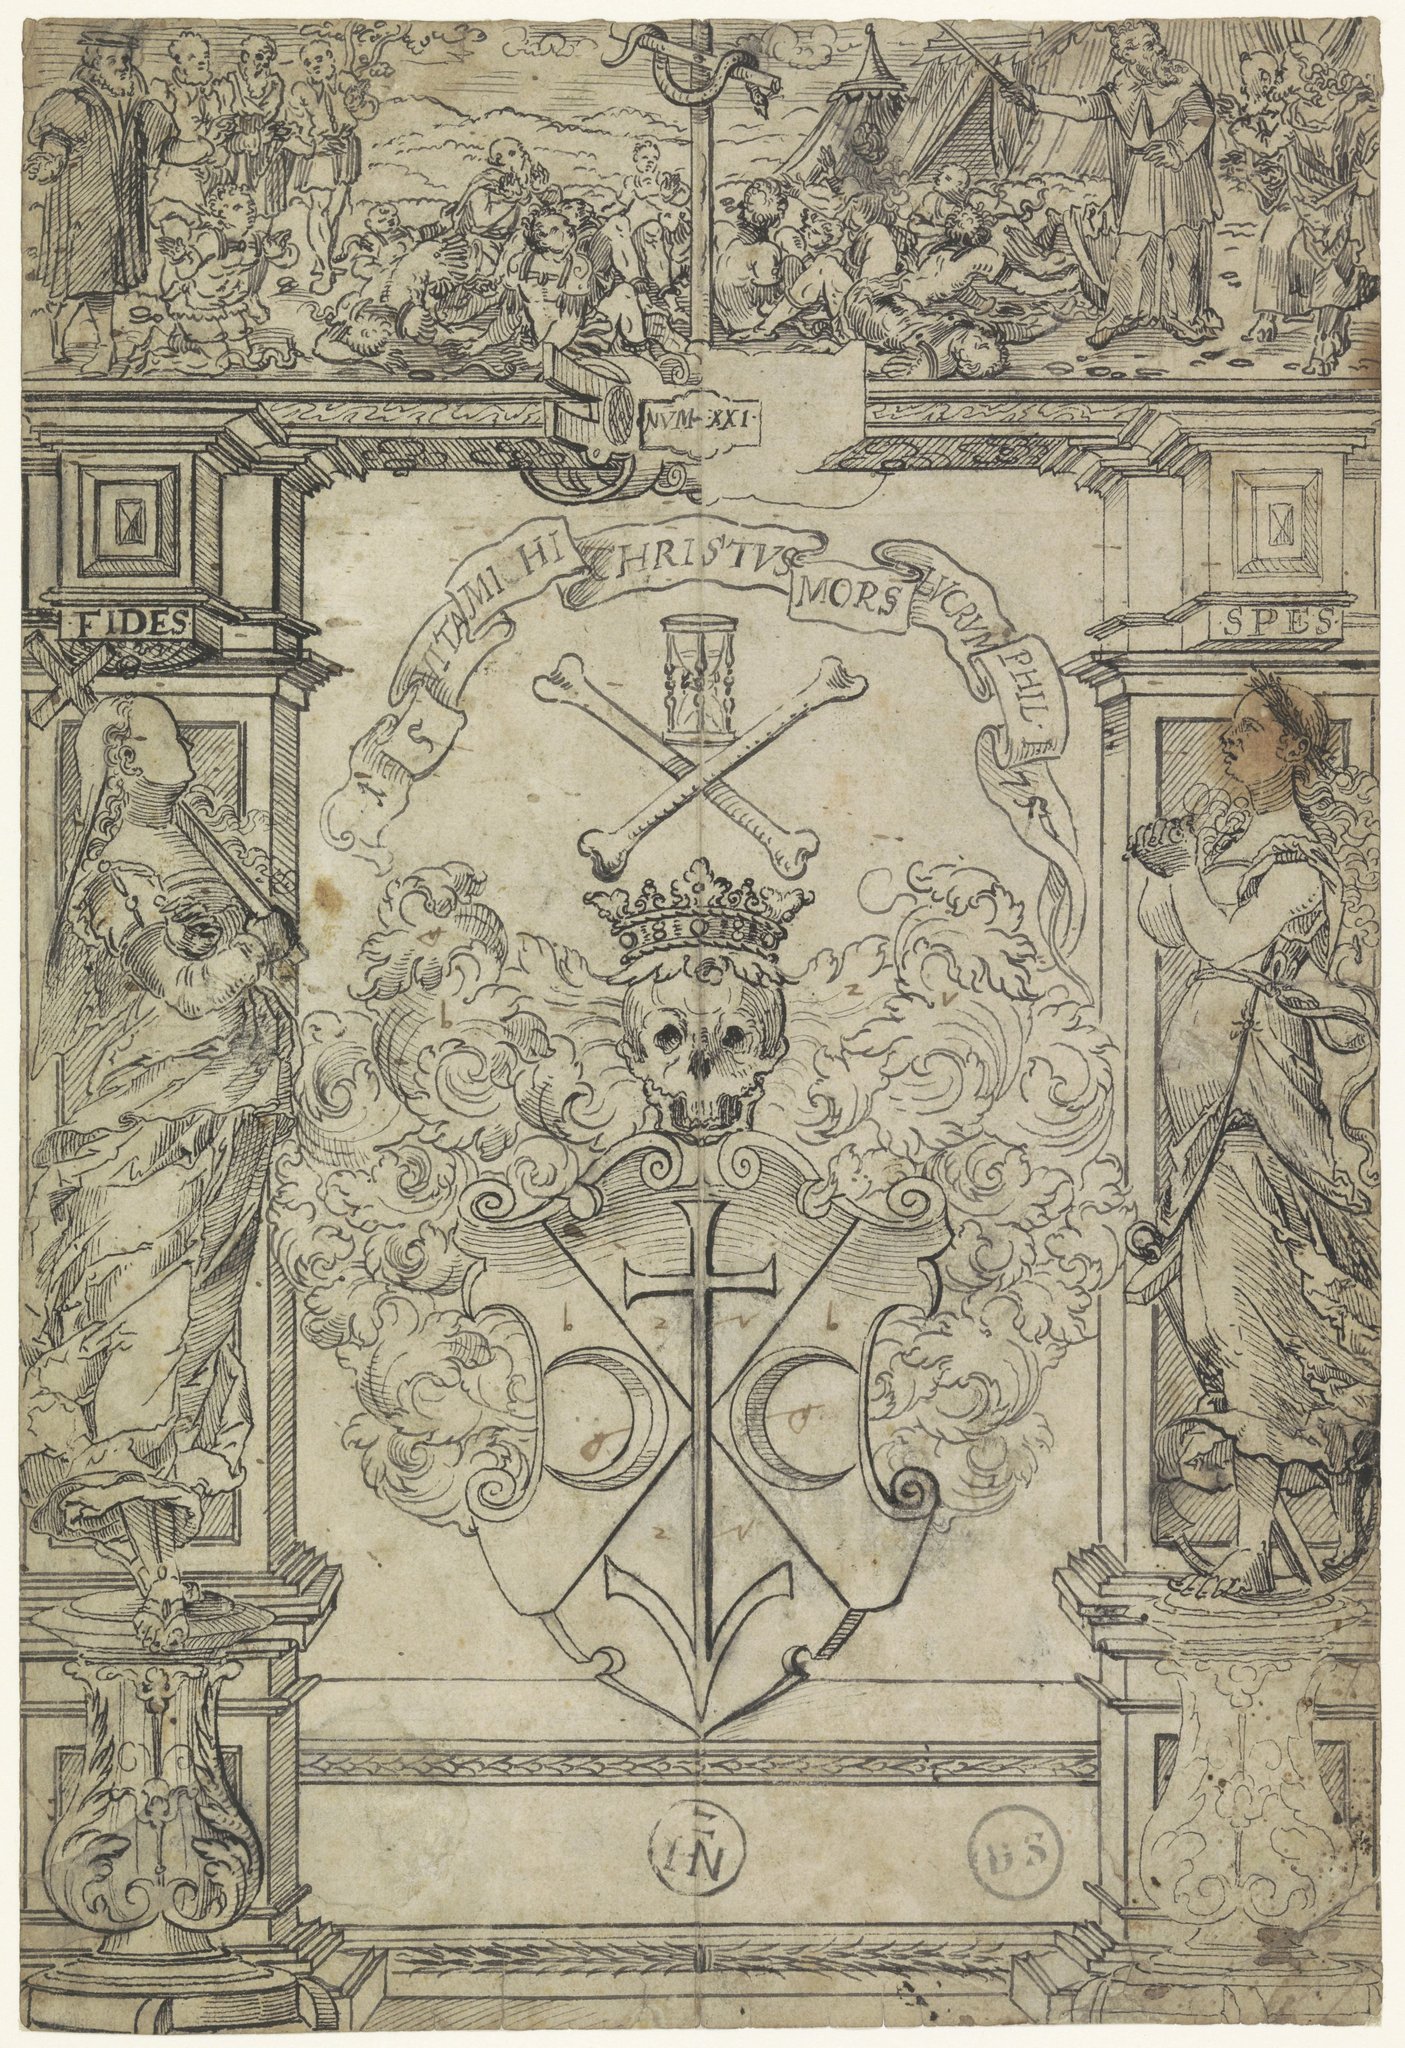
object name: drawing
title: Ontwerp voor een glasraam met een wapen, de figuren Fides en Spes, en Mozes en de koperen slang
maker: Anonymous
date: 1500-1600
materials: ink, paper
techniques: pen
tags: hope, 'spes'; 'speranza divina e certa' (ripa) ~ one of the three theological virtues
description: Ontwerp voor een glasraam met een onbekend familiewapen met vanitas symbool: gekroonde schedel Hoop en Geloof oprichting van koperen slang.